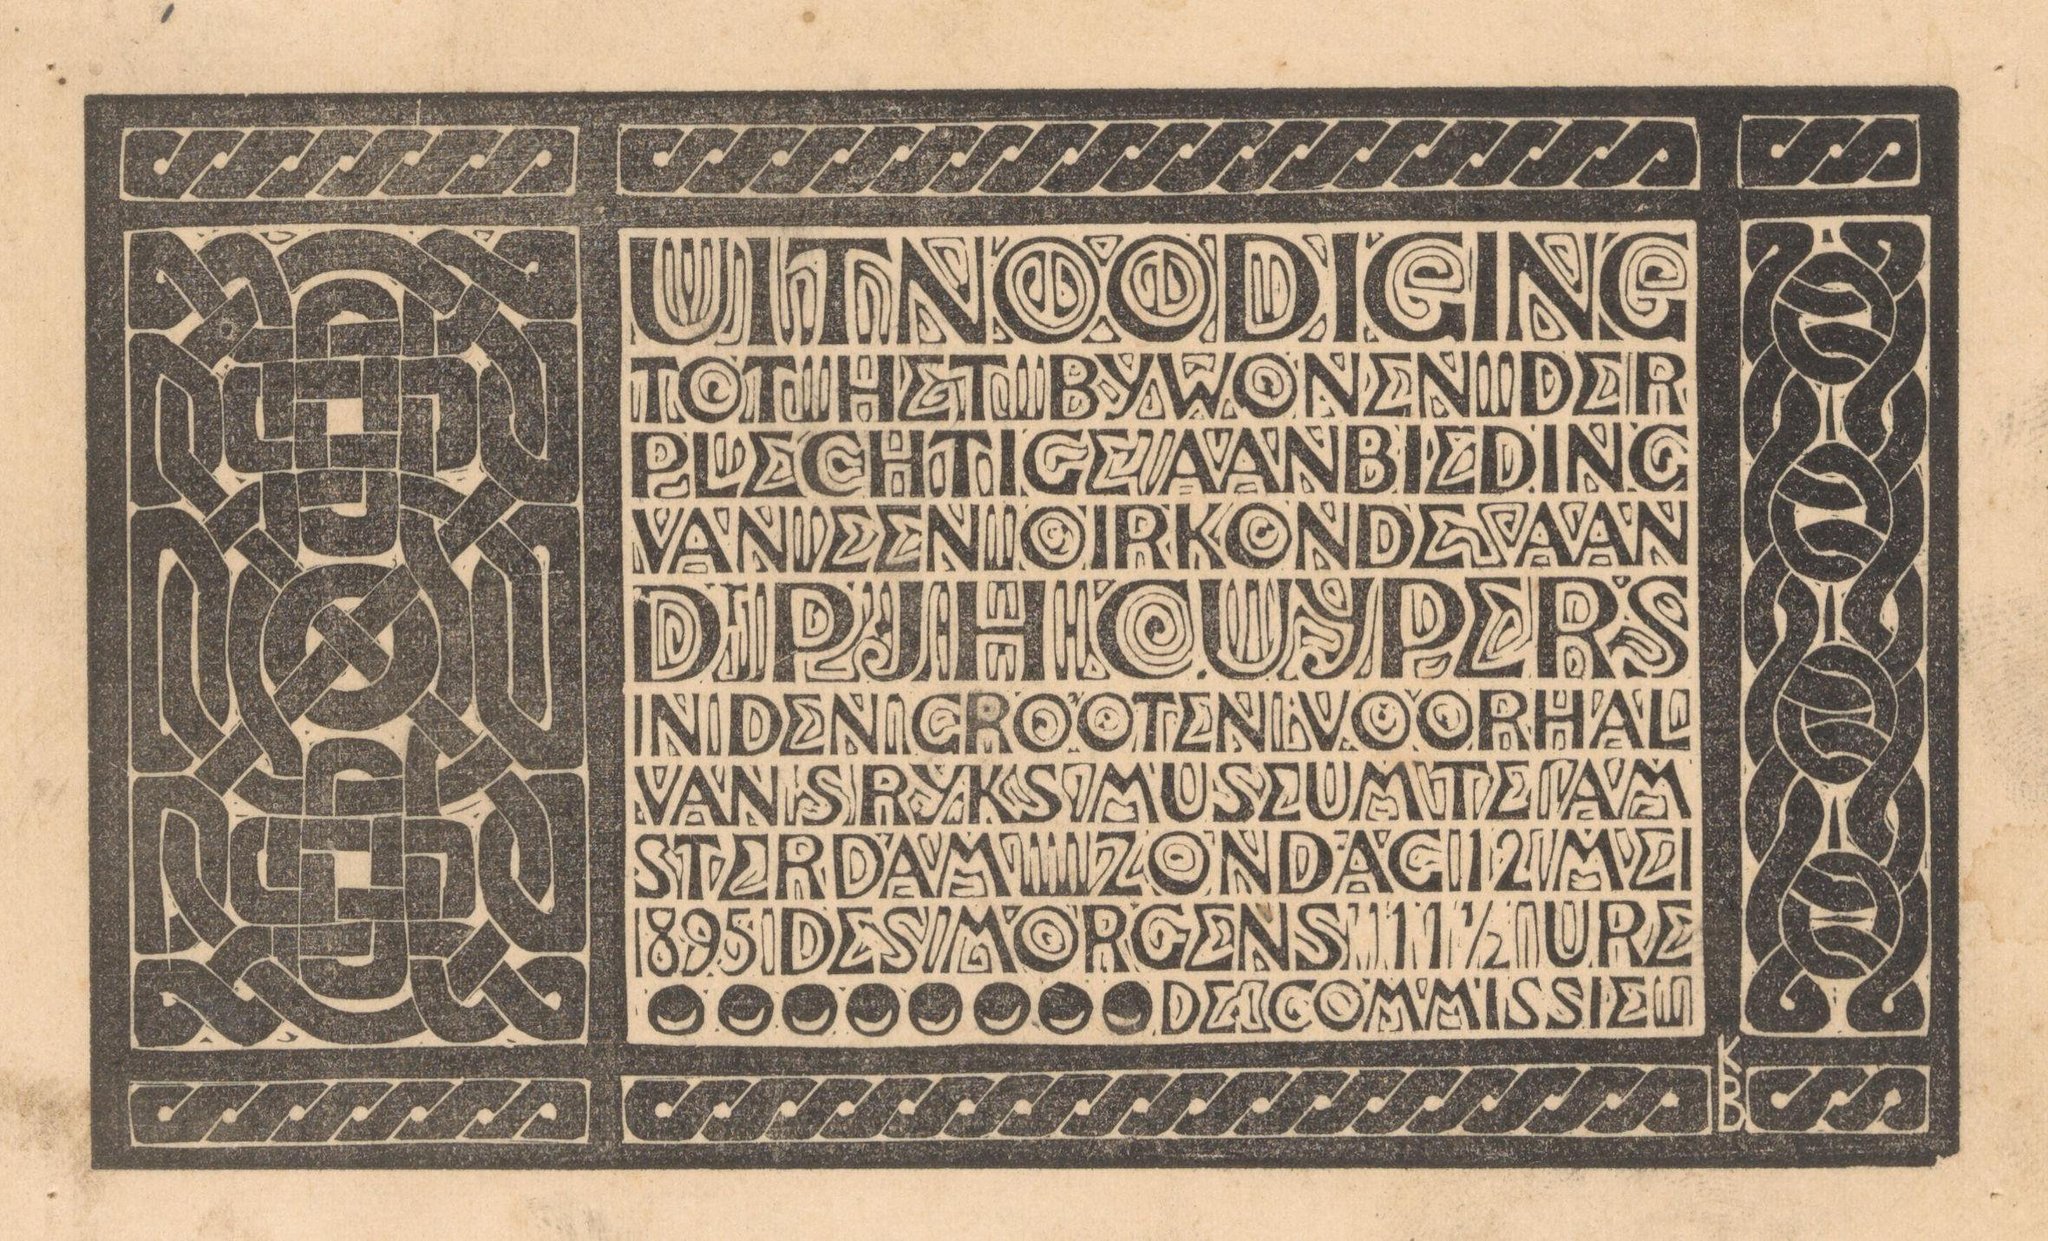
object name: invitation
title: Uitnodiging voor uitreiking van oorkonde aan Pierre Cuypers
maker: karel petrus cornelis de bazel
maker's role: draughtsman, print maker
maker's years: 1869-1923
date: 1895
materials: paper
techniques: woodcut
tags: pierre joseph hubert cuypers, postcard, picture-postcard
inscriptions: collector's mark: Lugt 2228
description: Uitnodiging met vlechtbandmotief voor de uitreiking van een oorkonde aan Pierre Cuypers in het Rijksmuseum op zondag 12 mei 1895.